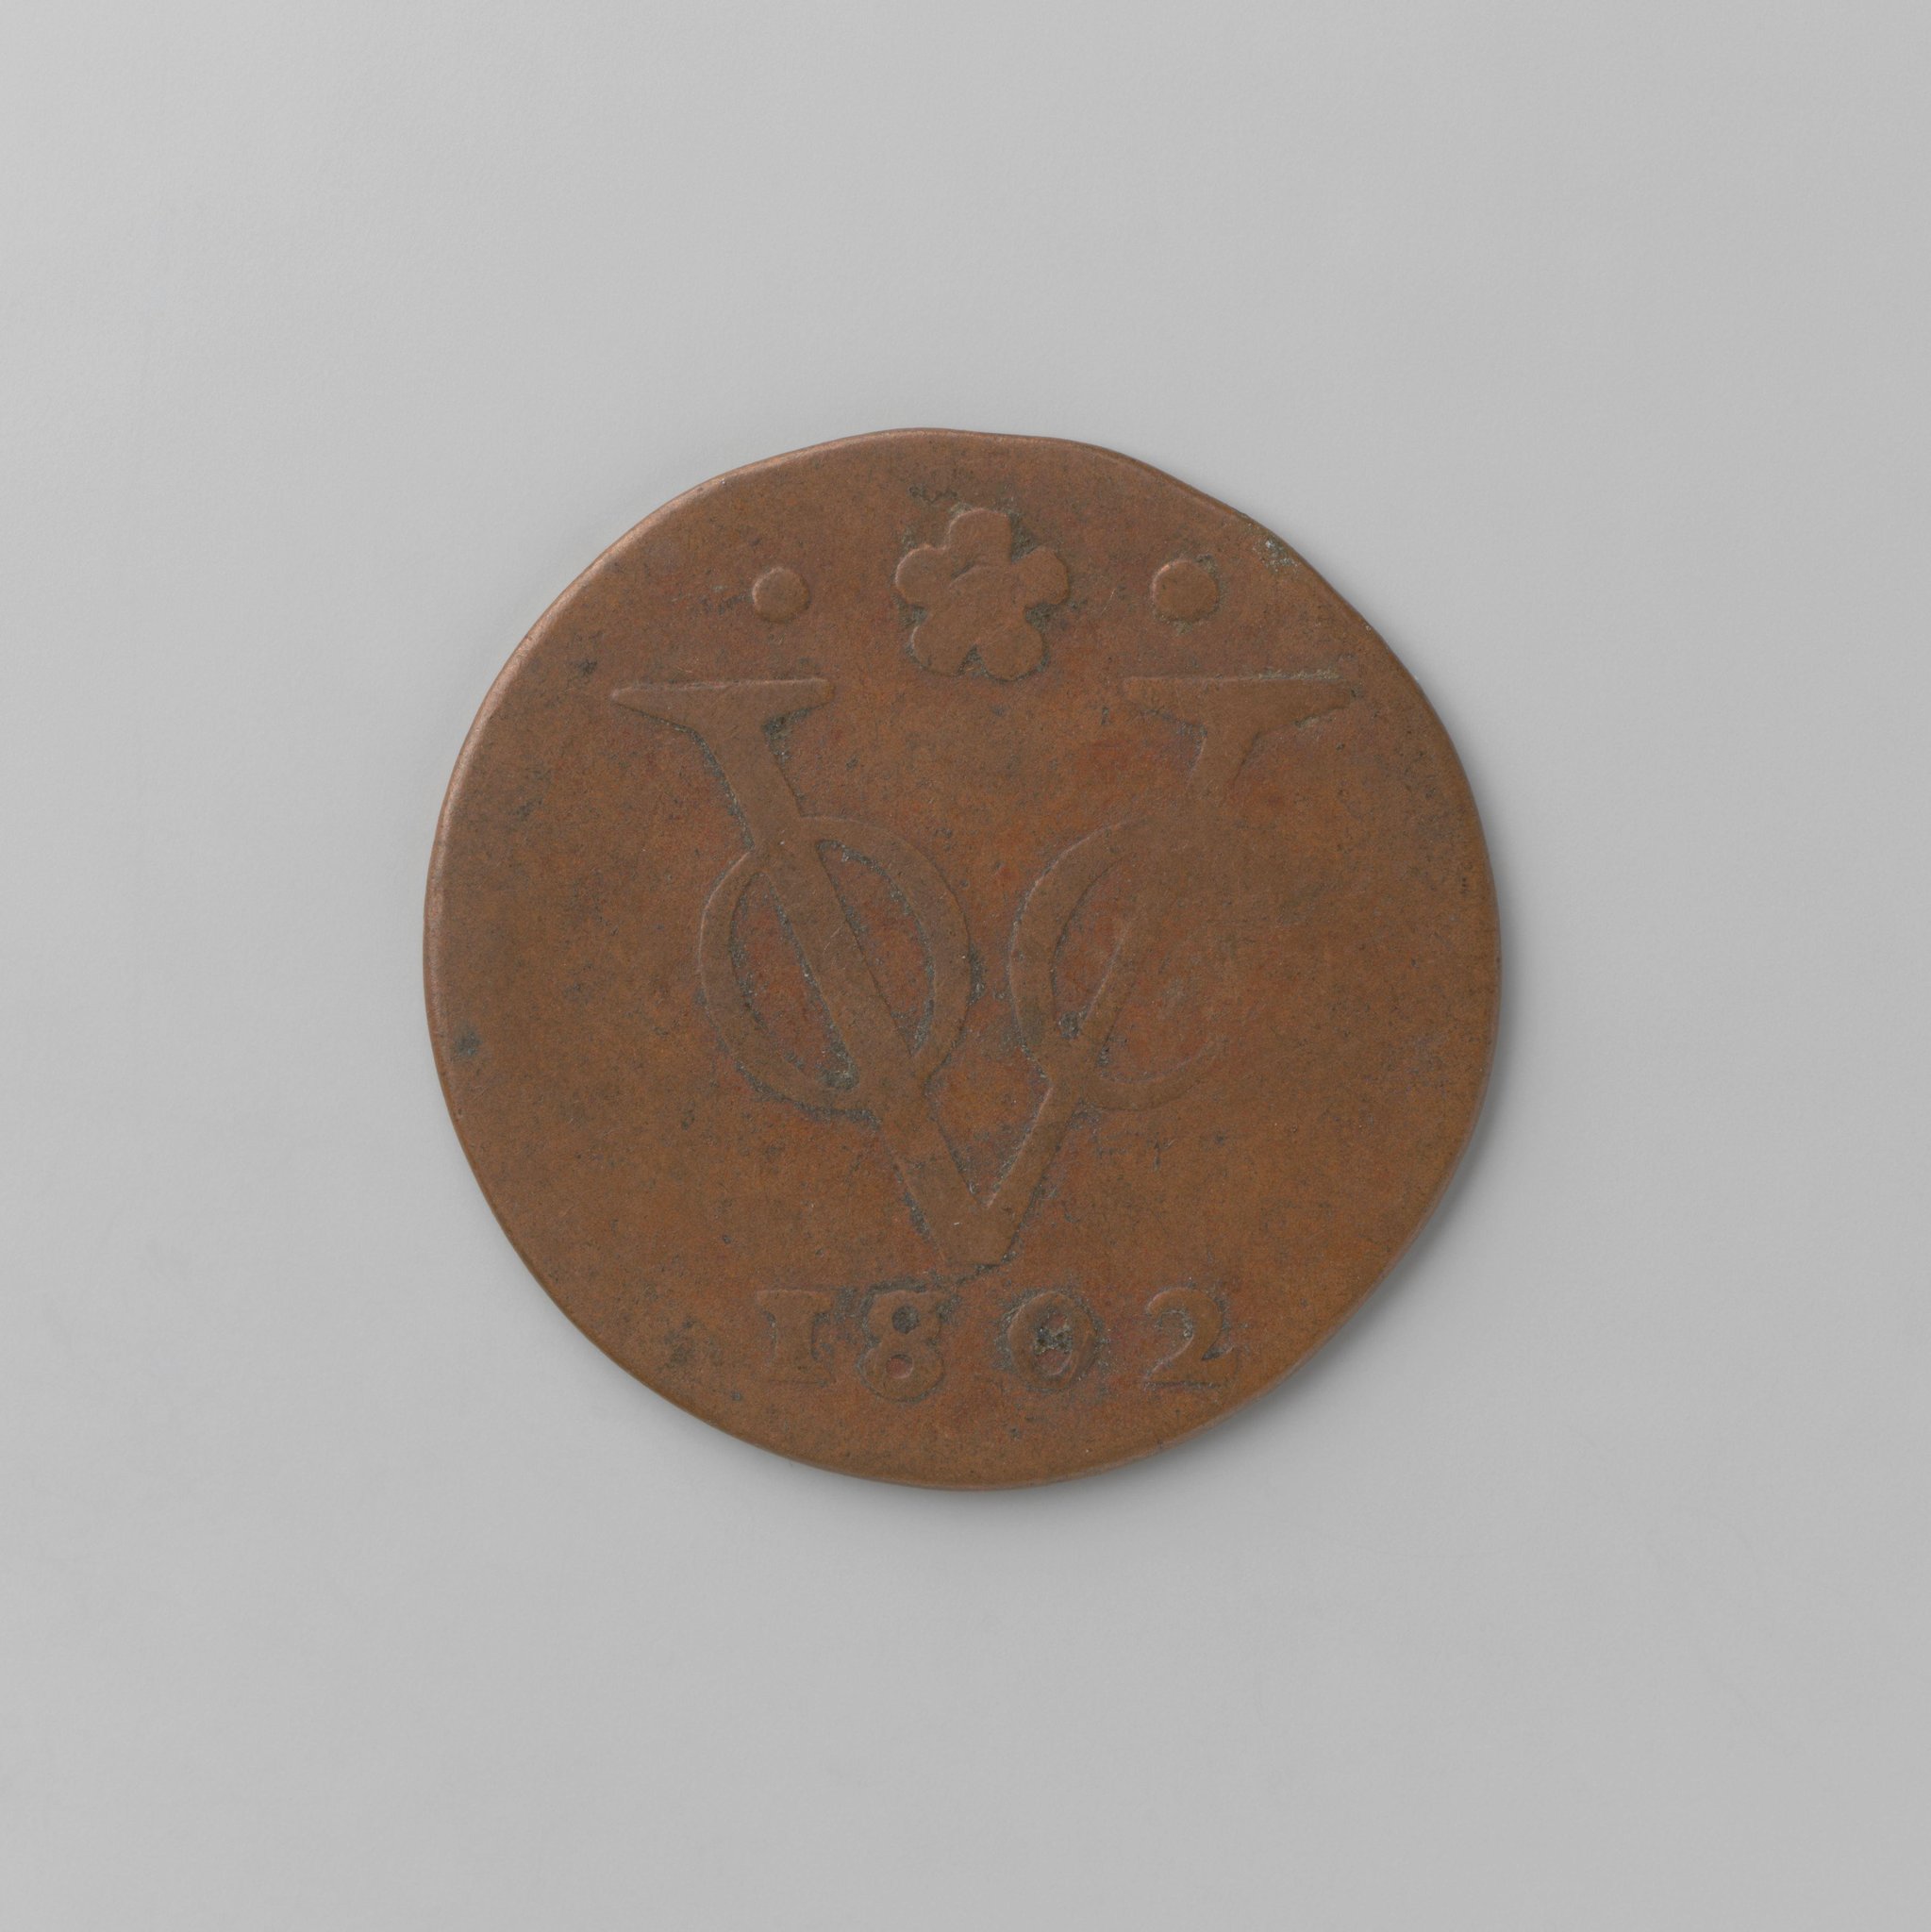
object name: coin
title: Duit voor Nederlands Indië uit Holland,1802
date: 1802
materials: copper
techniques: striking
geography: dordrecht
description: Koperen munt. Voorzijde: gekroond wapenschild van Holland. Keerzijde: monogram van de VOC, waarboven muntteken rozet en waaronder jaartal. Gladde rand.